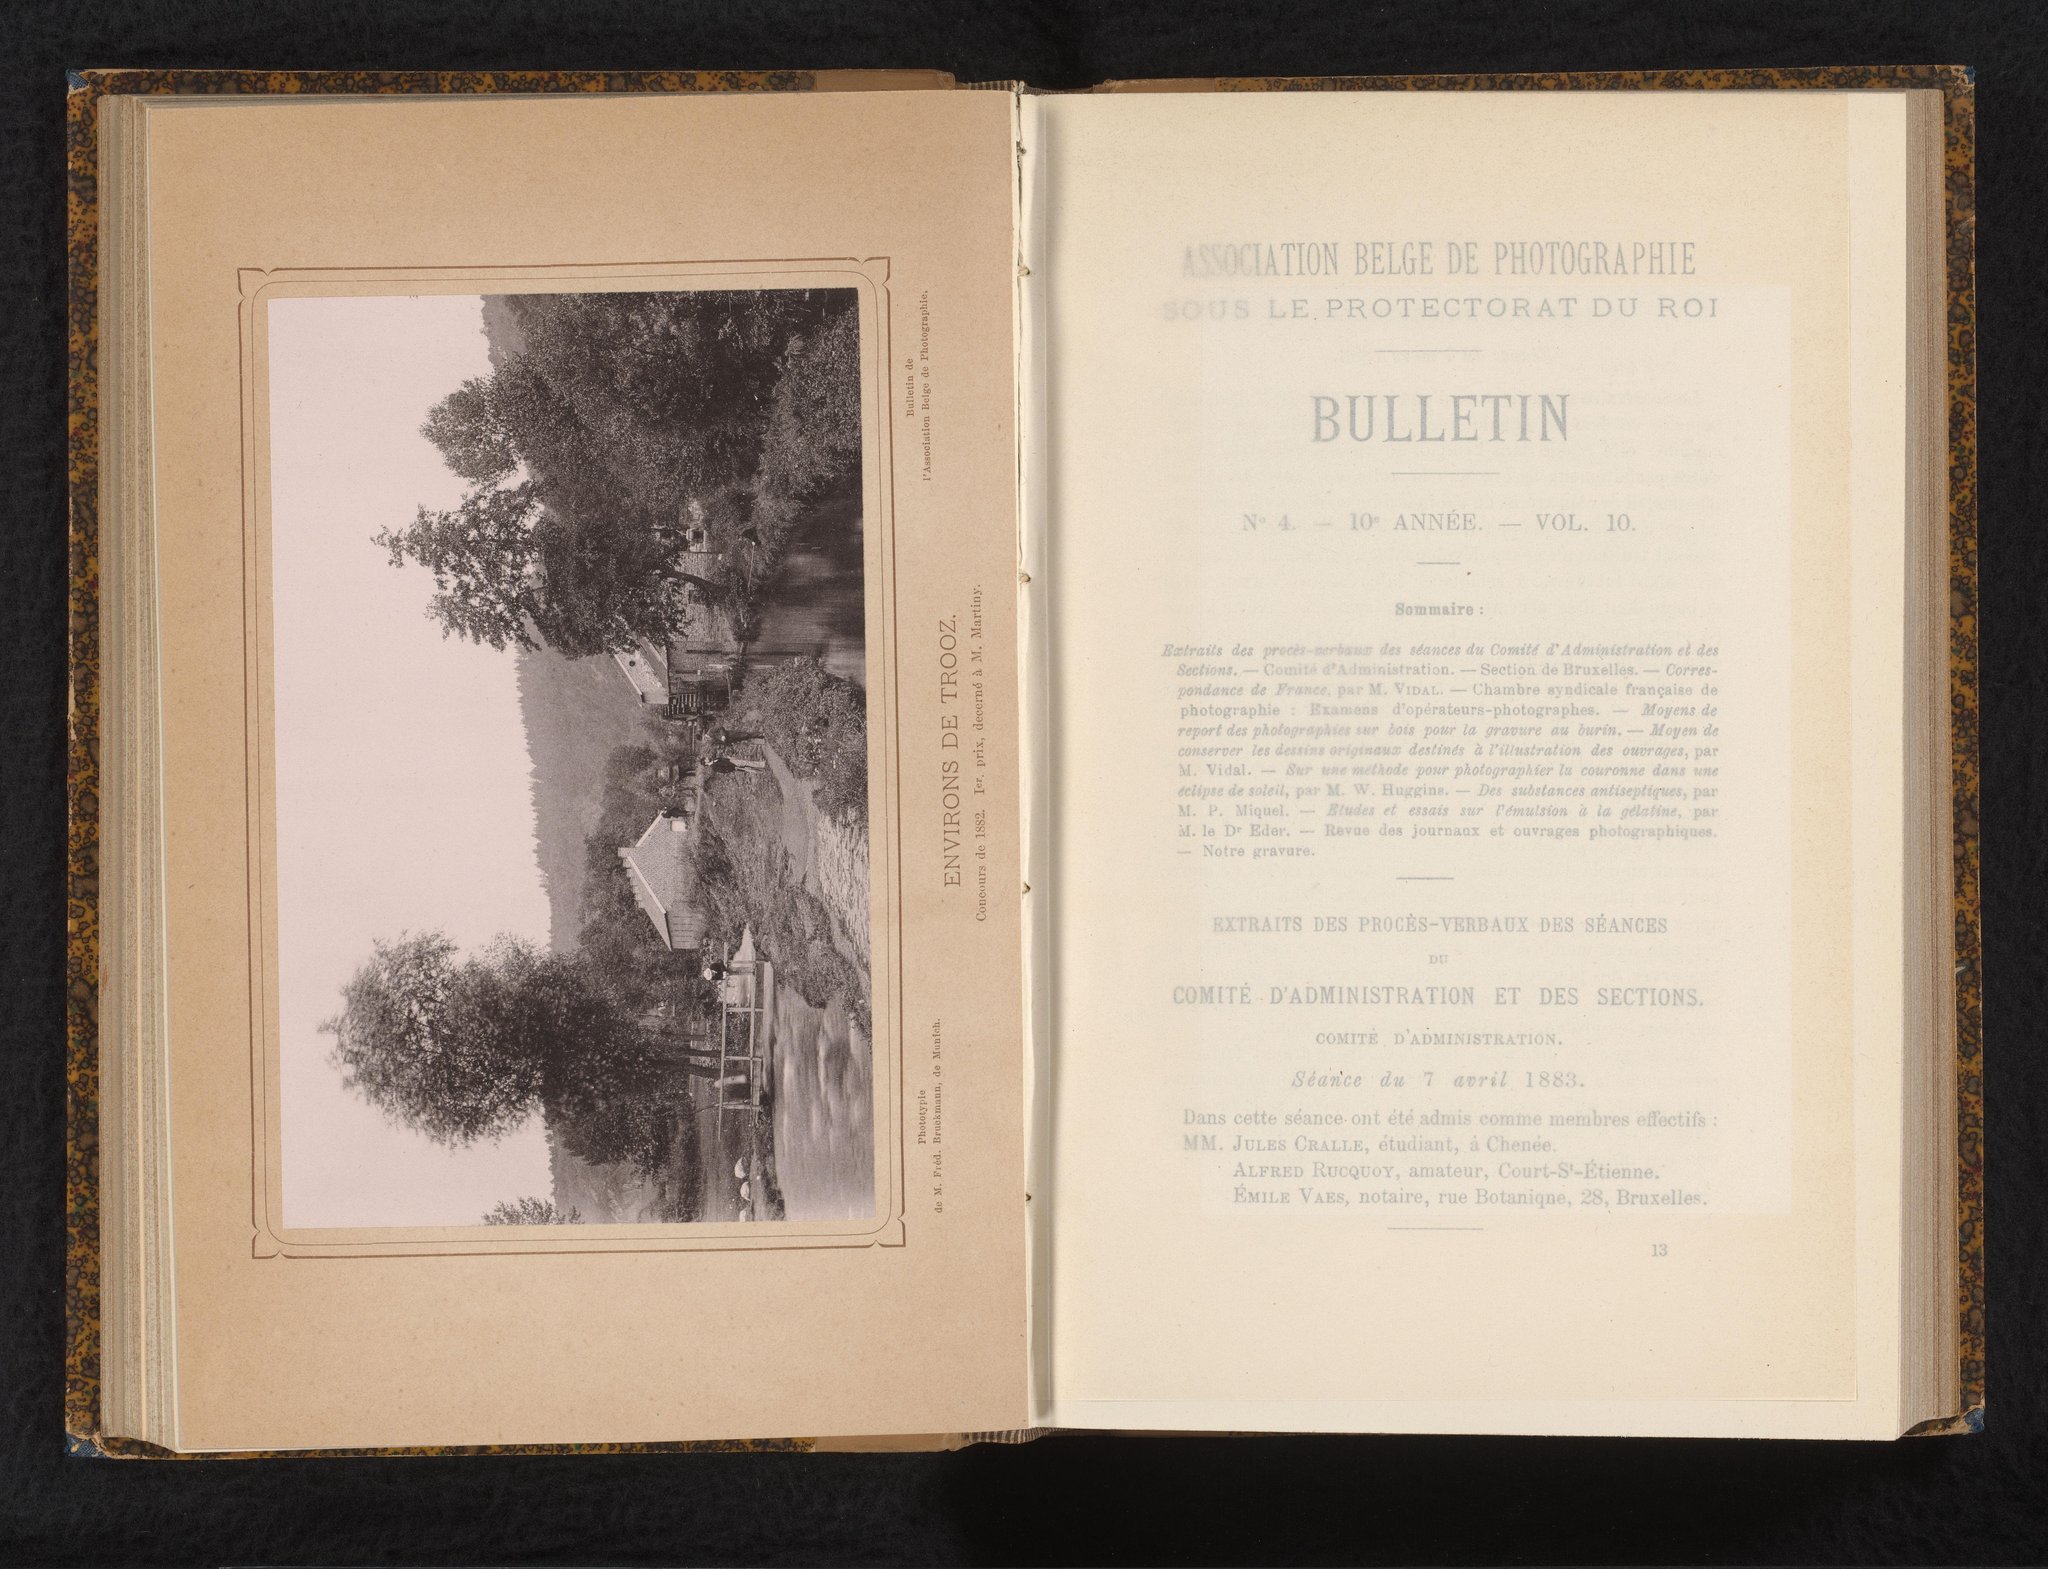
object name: page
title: Watermolen in de omgeving van Trooz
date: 1877-1882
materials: cardboard, paper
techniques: photograph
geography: munich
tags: brook, watermill in landscape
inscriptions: inscription: ‘Concours de 1882. Ier prix, decerné à M. Martiny.’